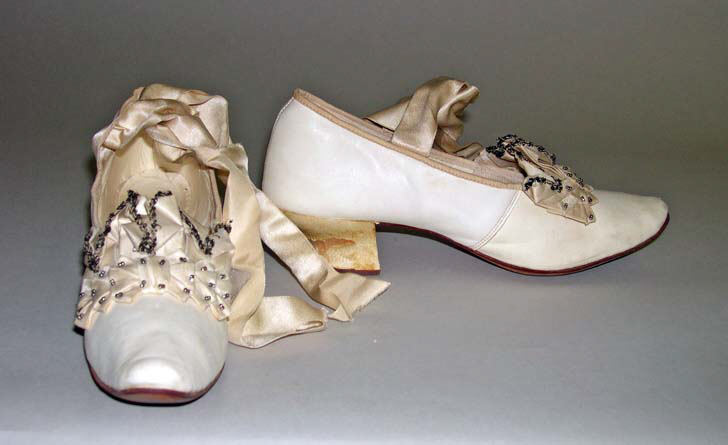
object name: slipper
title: Slippers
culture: american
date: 1880-1889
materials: leather, silk